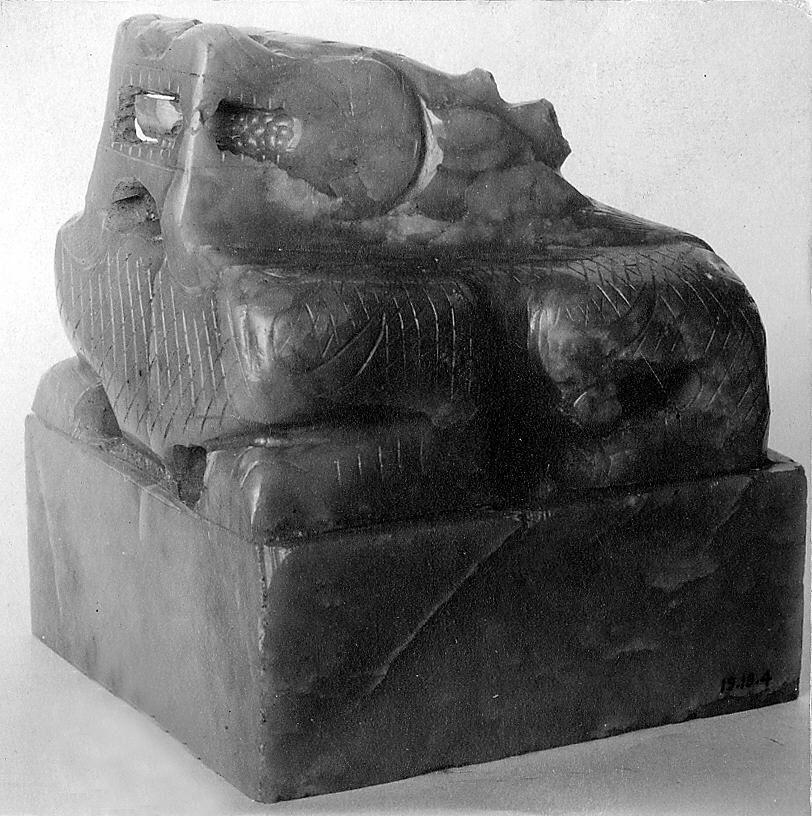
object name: seal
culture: chinese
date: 1368-1644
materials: jade